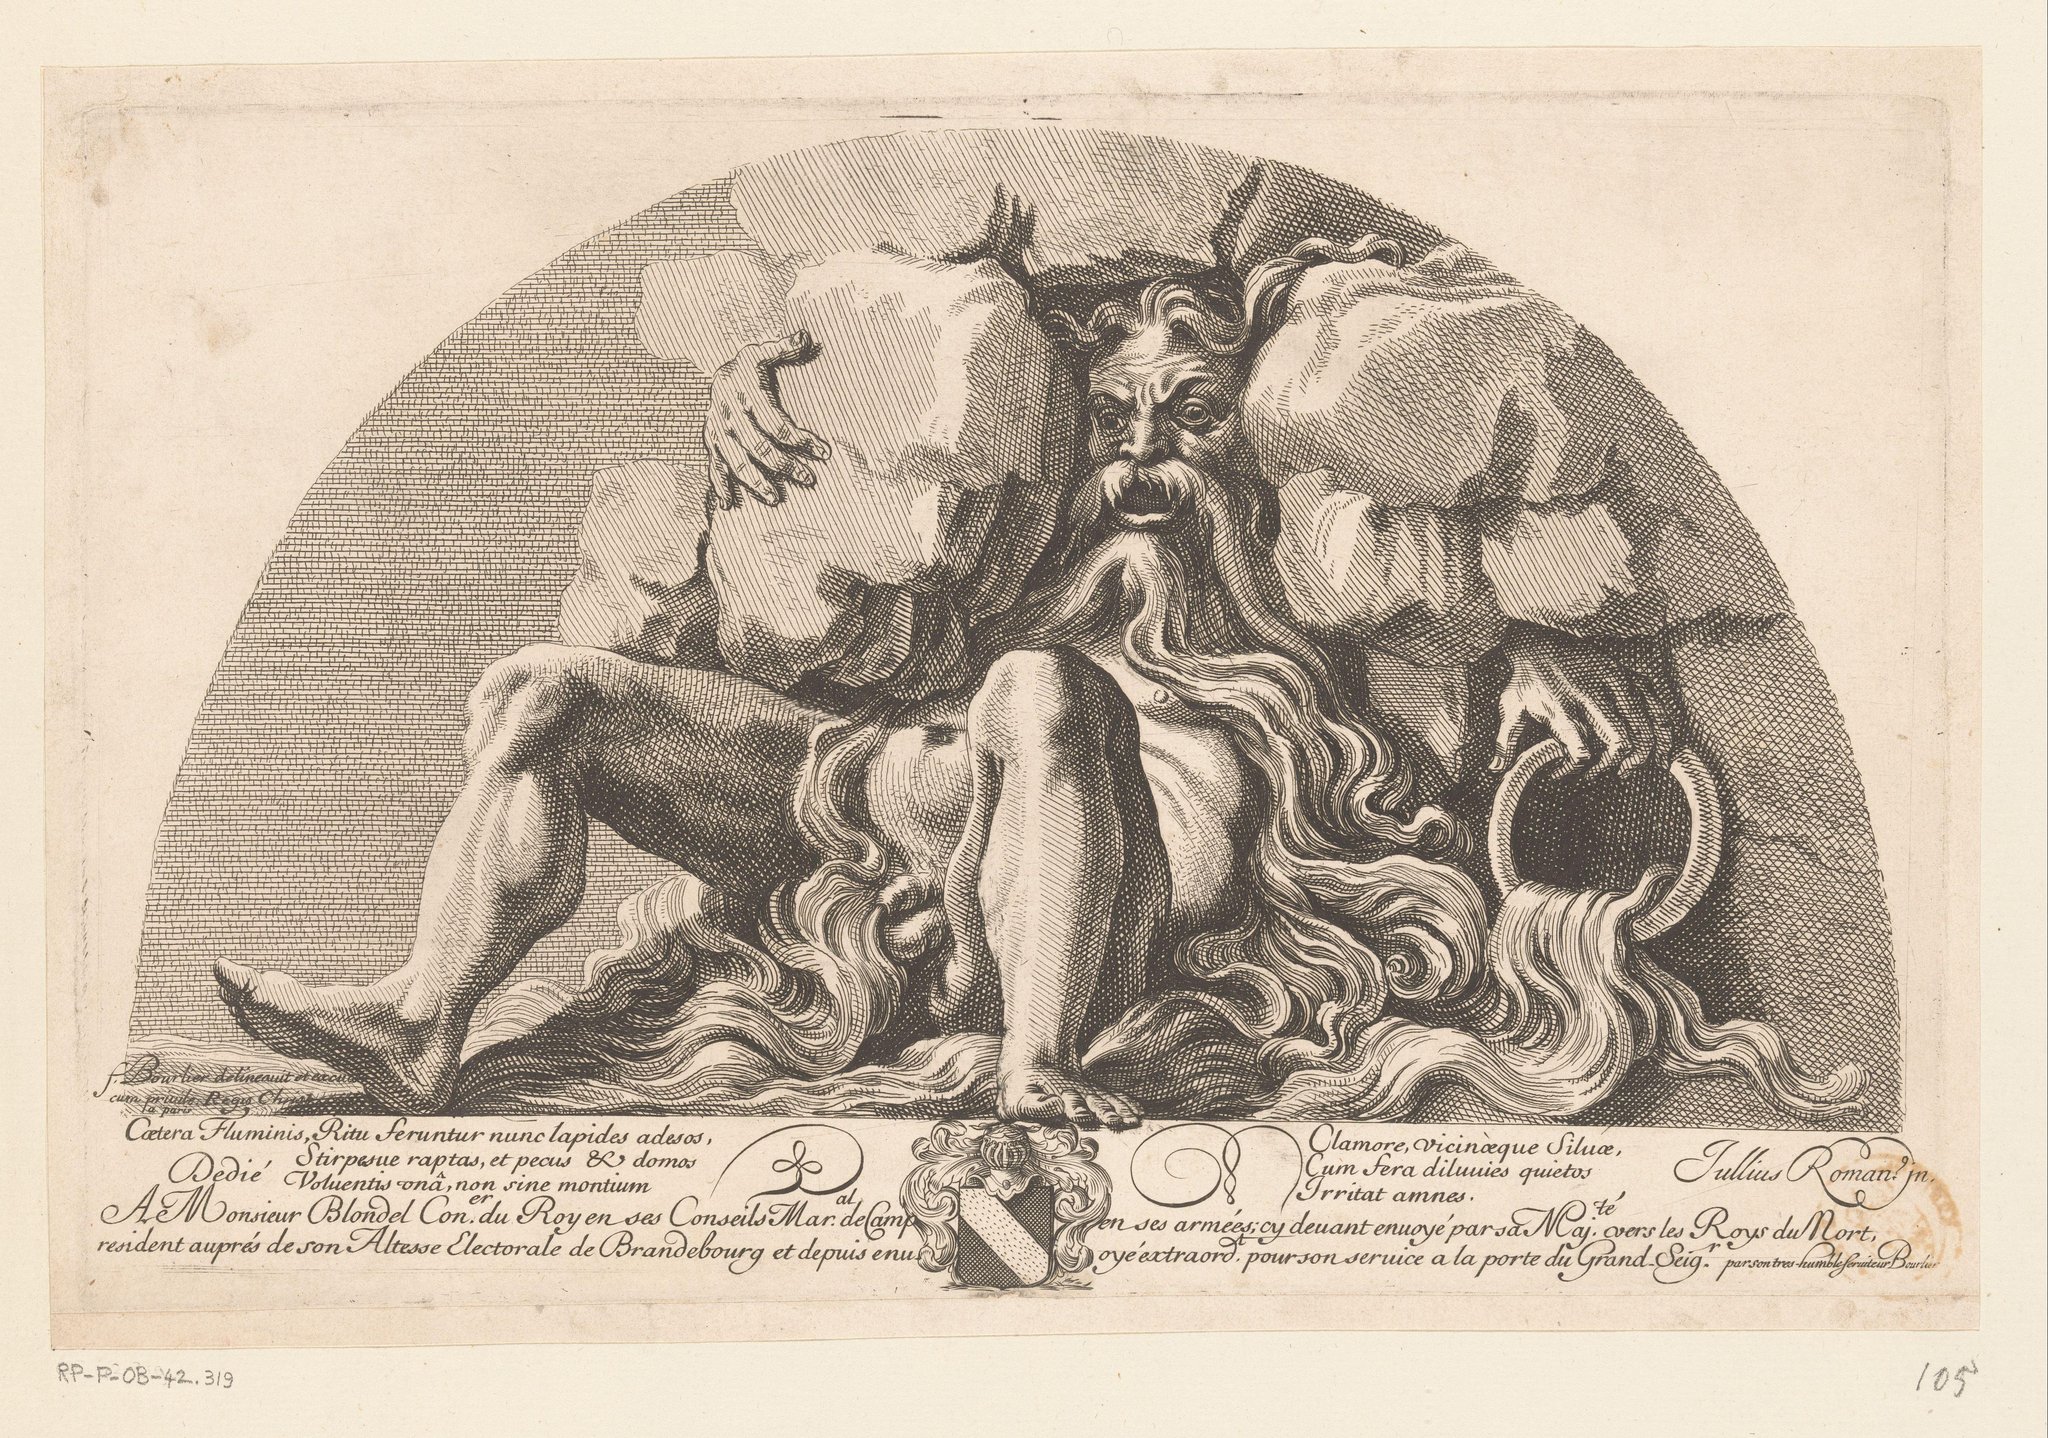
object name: print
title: Riviergod beklemd door keien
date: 1651-1682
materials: paper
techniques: engraving, etching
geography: paris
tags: river-gods, rocks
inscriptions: collector's mark: Lugt 240